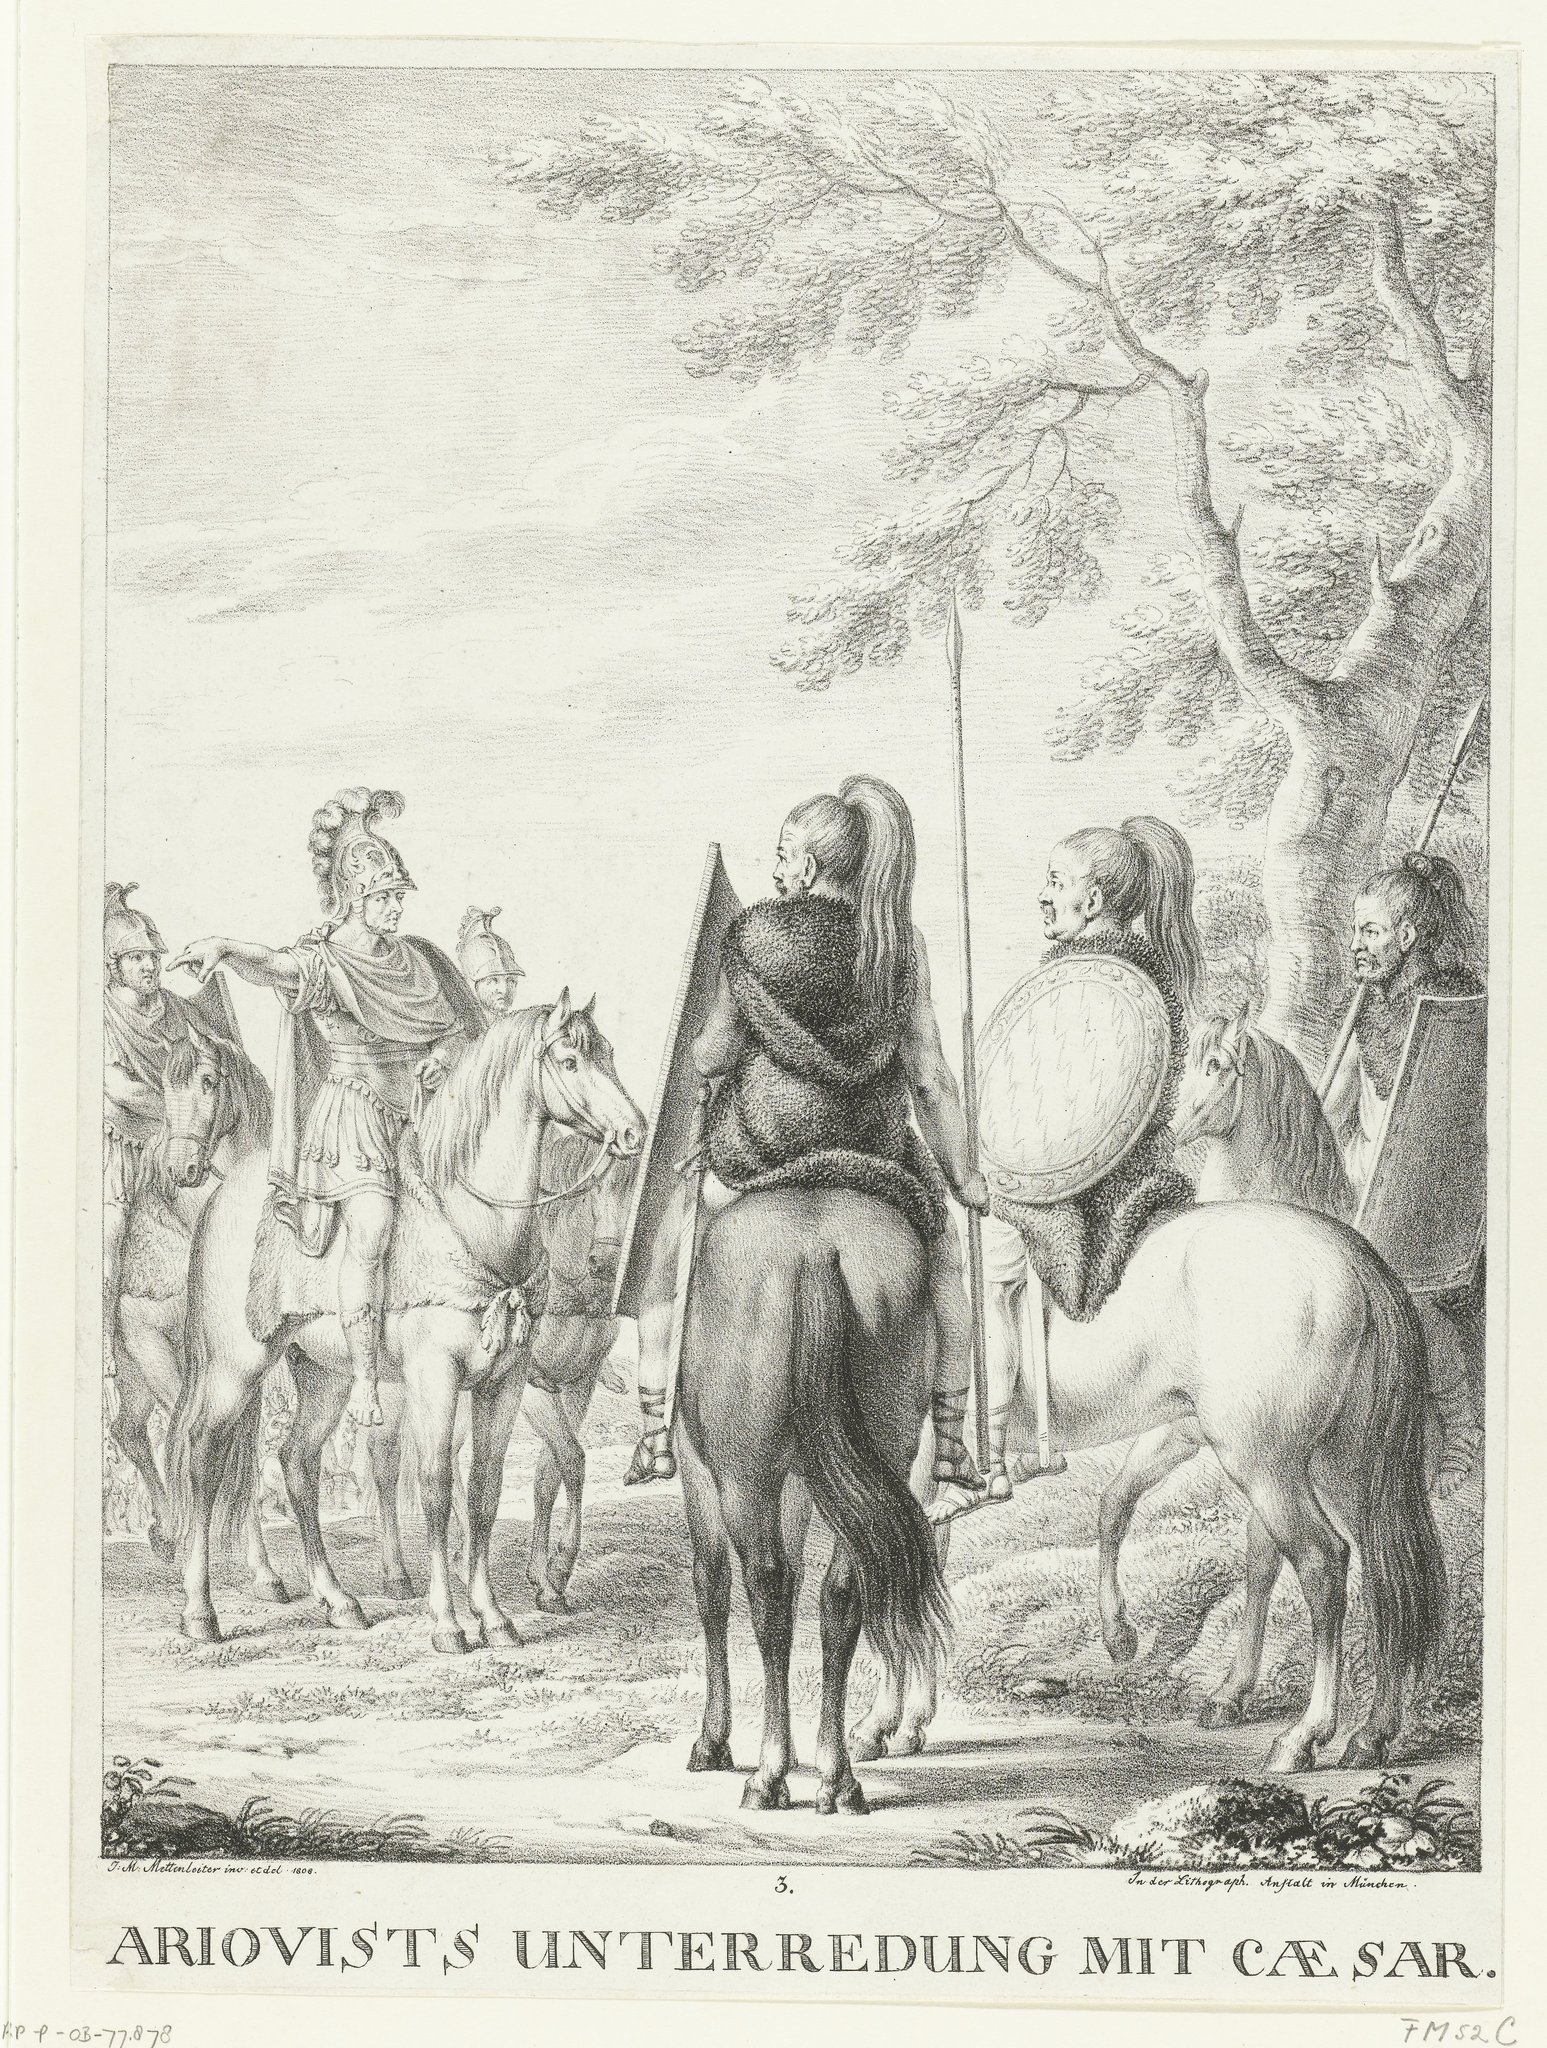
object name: print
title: Ariovistus in confrontatie met Caesar, 58 v.C.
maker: johann michael mettenleiter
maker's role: print maker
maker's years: 1765-1853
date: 1808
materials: paper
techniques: lithograph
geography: germany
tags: rome, extinct, 'historical' peoples (with name)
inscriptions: date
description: De Germaanse leider Ariovistus in overleg met Julius Caesar, waarschijnlijk voorafgaand aan de veldslag bij Besançon in 58 v.C.